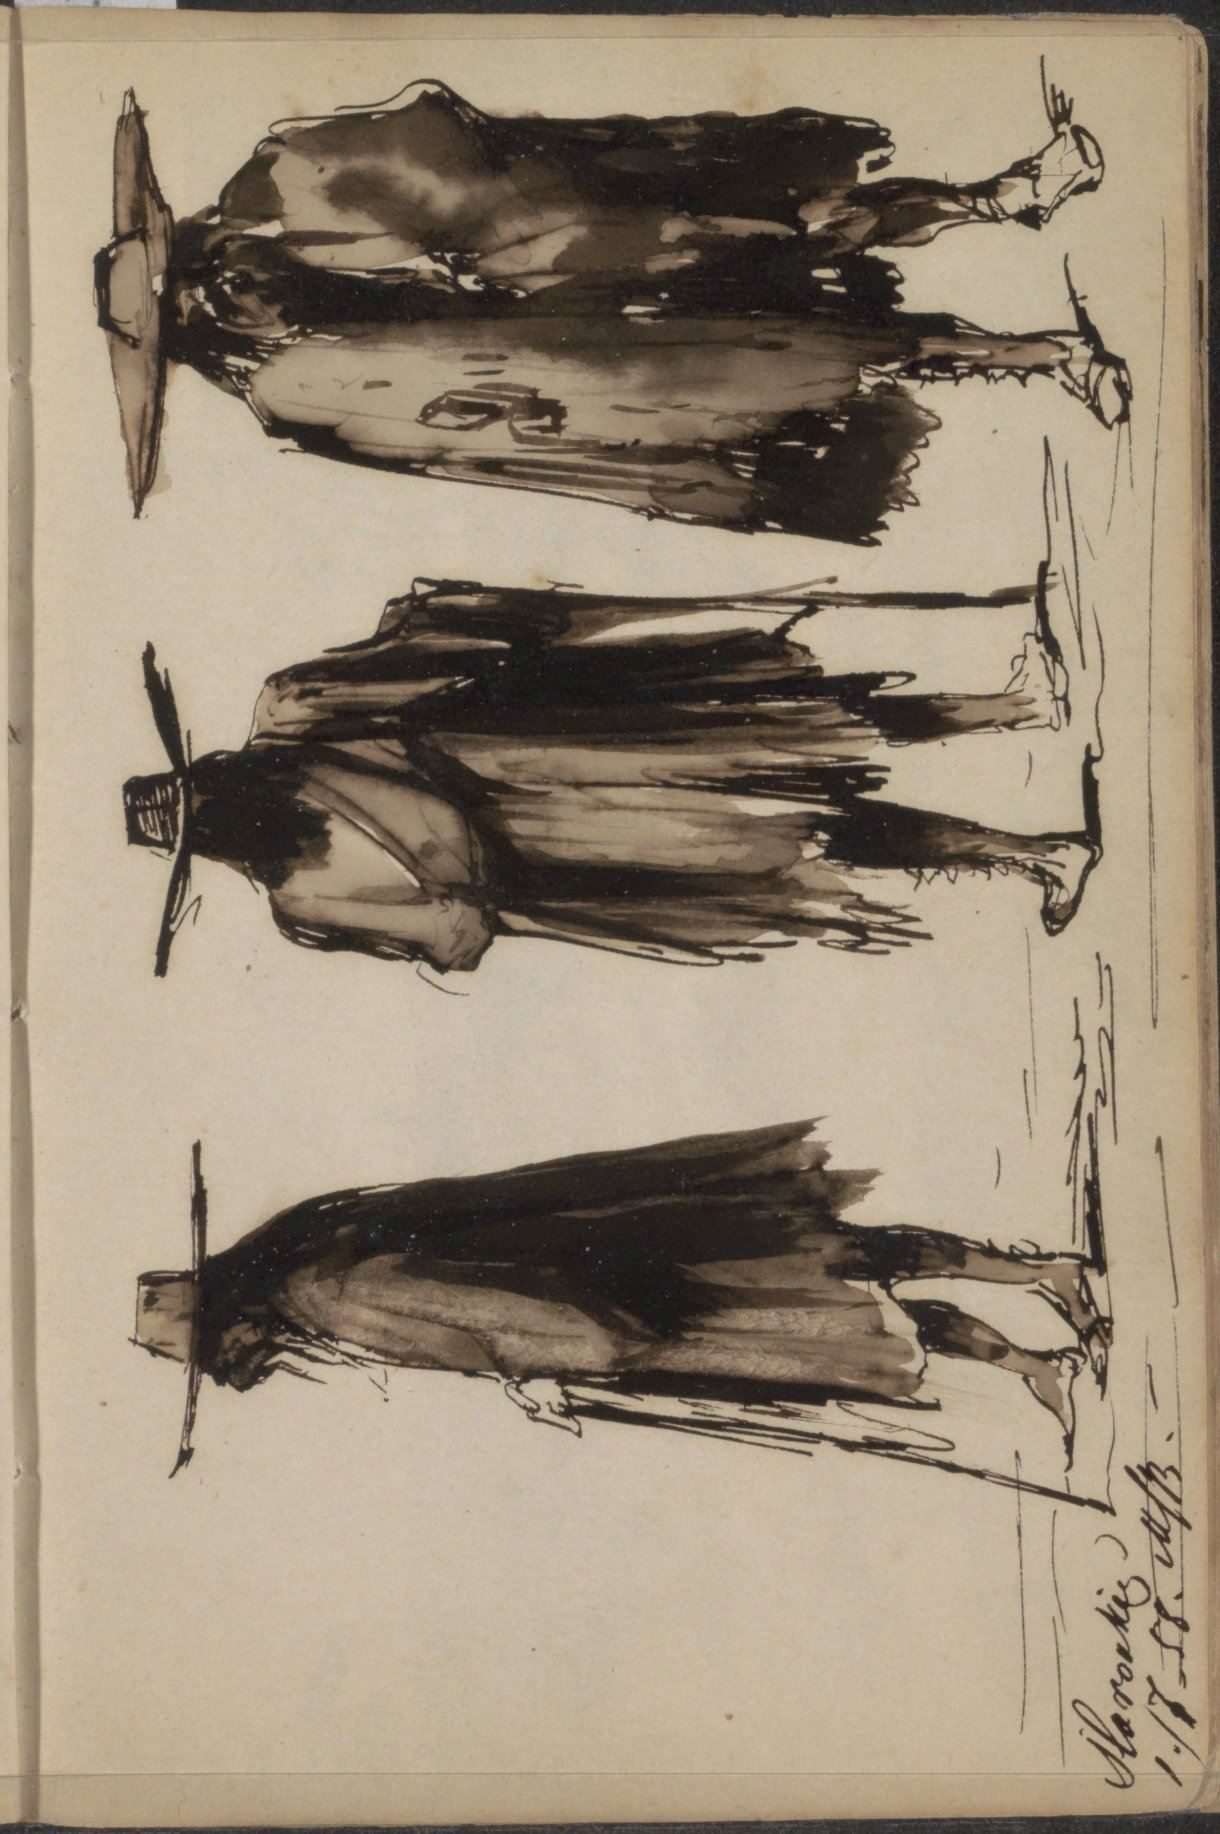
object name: sketchbook leaf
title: Man met lange haren en een wandelstok in een versleten mantel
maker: johannes tavenraat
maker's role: draughtsman, painter, print maker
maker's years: 1809-1881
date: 1807-1858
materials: ink, paper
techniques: brush, pen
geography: marienbad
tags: standing figure, coat (+ men's clothes), walking-stick, staff, adult man, head-gear: hat (+ men's clothes), marienbad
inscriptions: date and inscription: ‘slaro[...]k[...]/ 1.7/ 58 MB’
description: Blad 34 recto uit een schetsboek met 44 bladen.